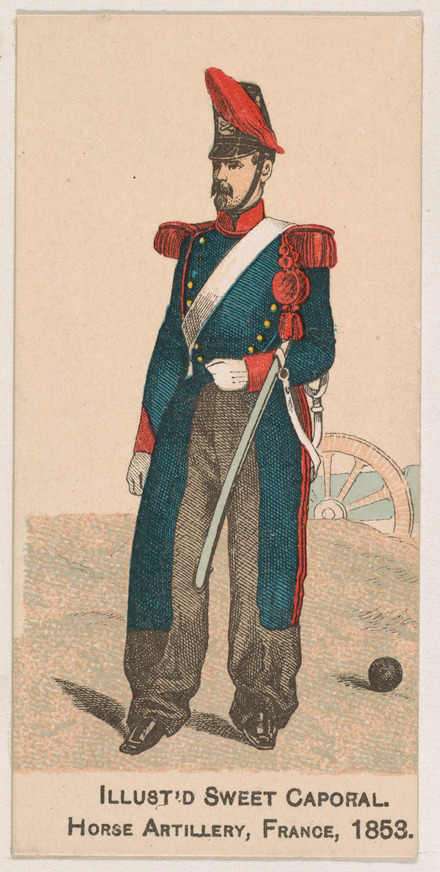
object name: print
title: Horse Artillery, France, 1853, from the Military Series (N224) issued by Kinney Tobacco Company to promote Sweet Caporal Cigarettes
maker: kinney brothers tobacco company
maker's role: publisher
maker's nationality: american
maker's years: 1869-2011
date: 1888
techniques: color lithograph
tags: soldiers,men